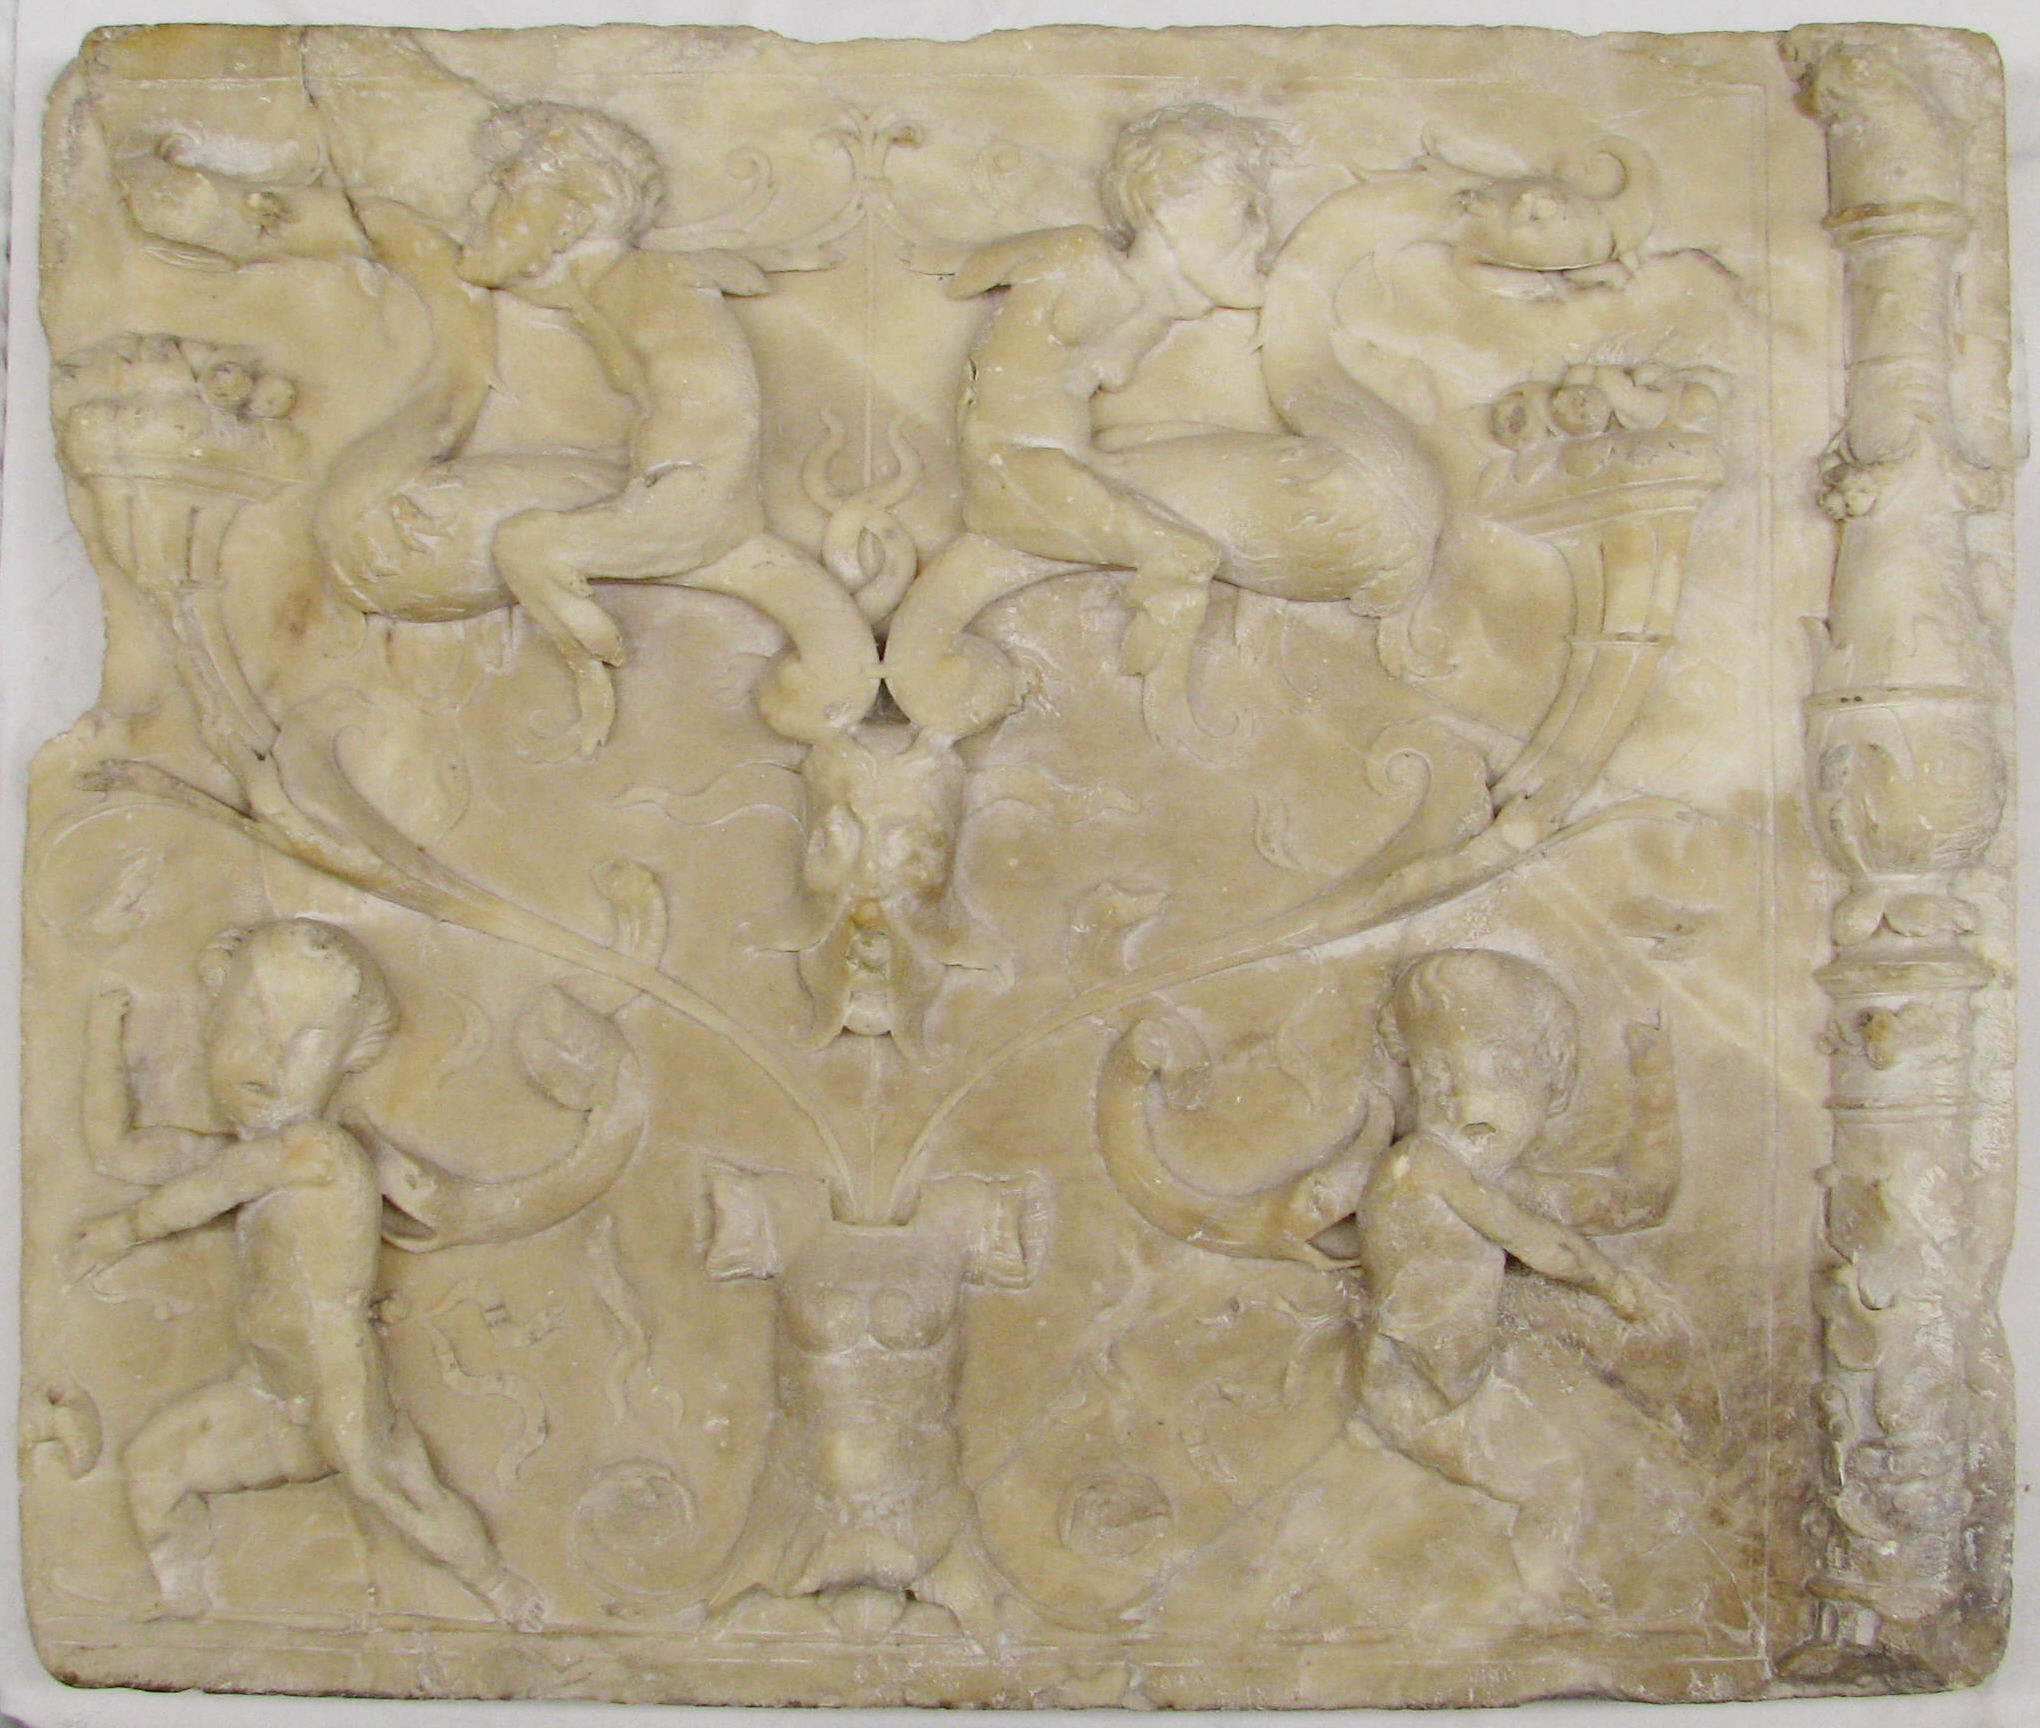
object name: panel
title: Architectural ornament panel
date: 1534-1566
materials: alabaster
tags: human figures,animals